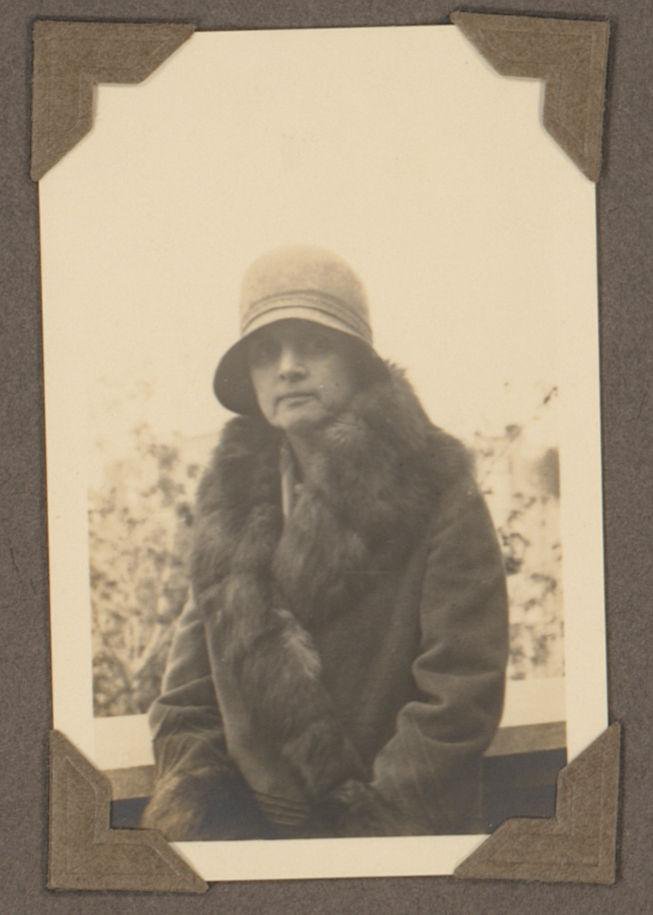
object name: album leaf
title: Portret van Henriëtte Wassink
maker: Anonymous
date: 1930-1935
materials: paper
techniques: gelatin silver print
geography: netherlands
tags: batavia, the hague, henriëtte wassink, adult woman, historical persons - bb - woman, netherlands